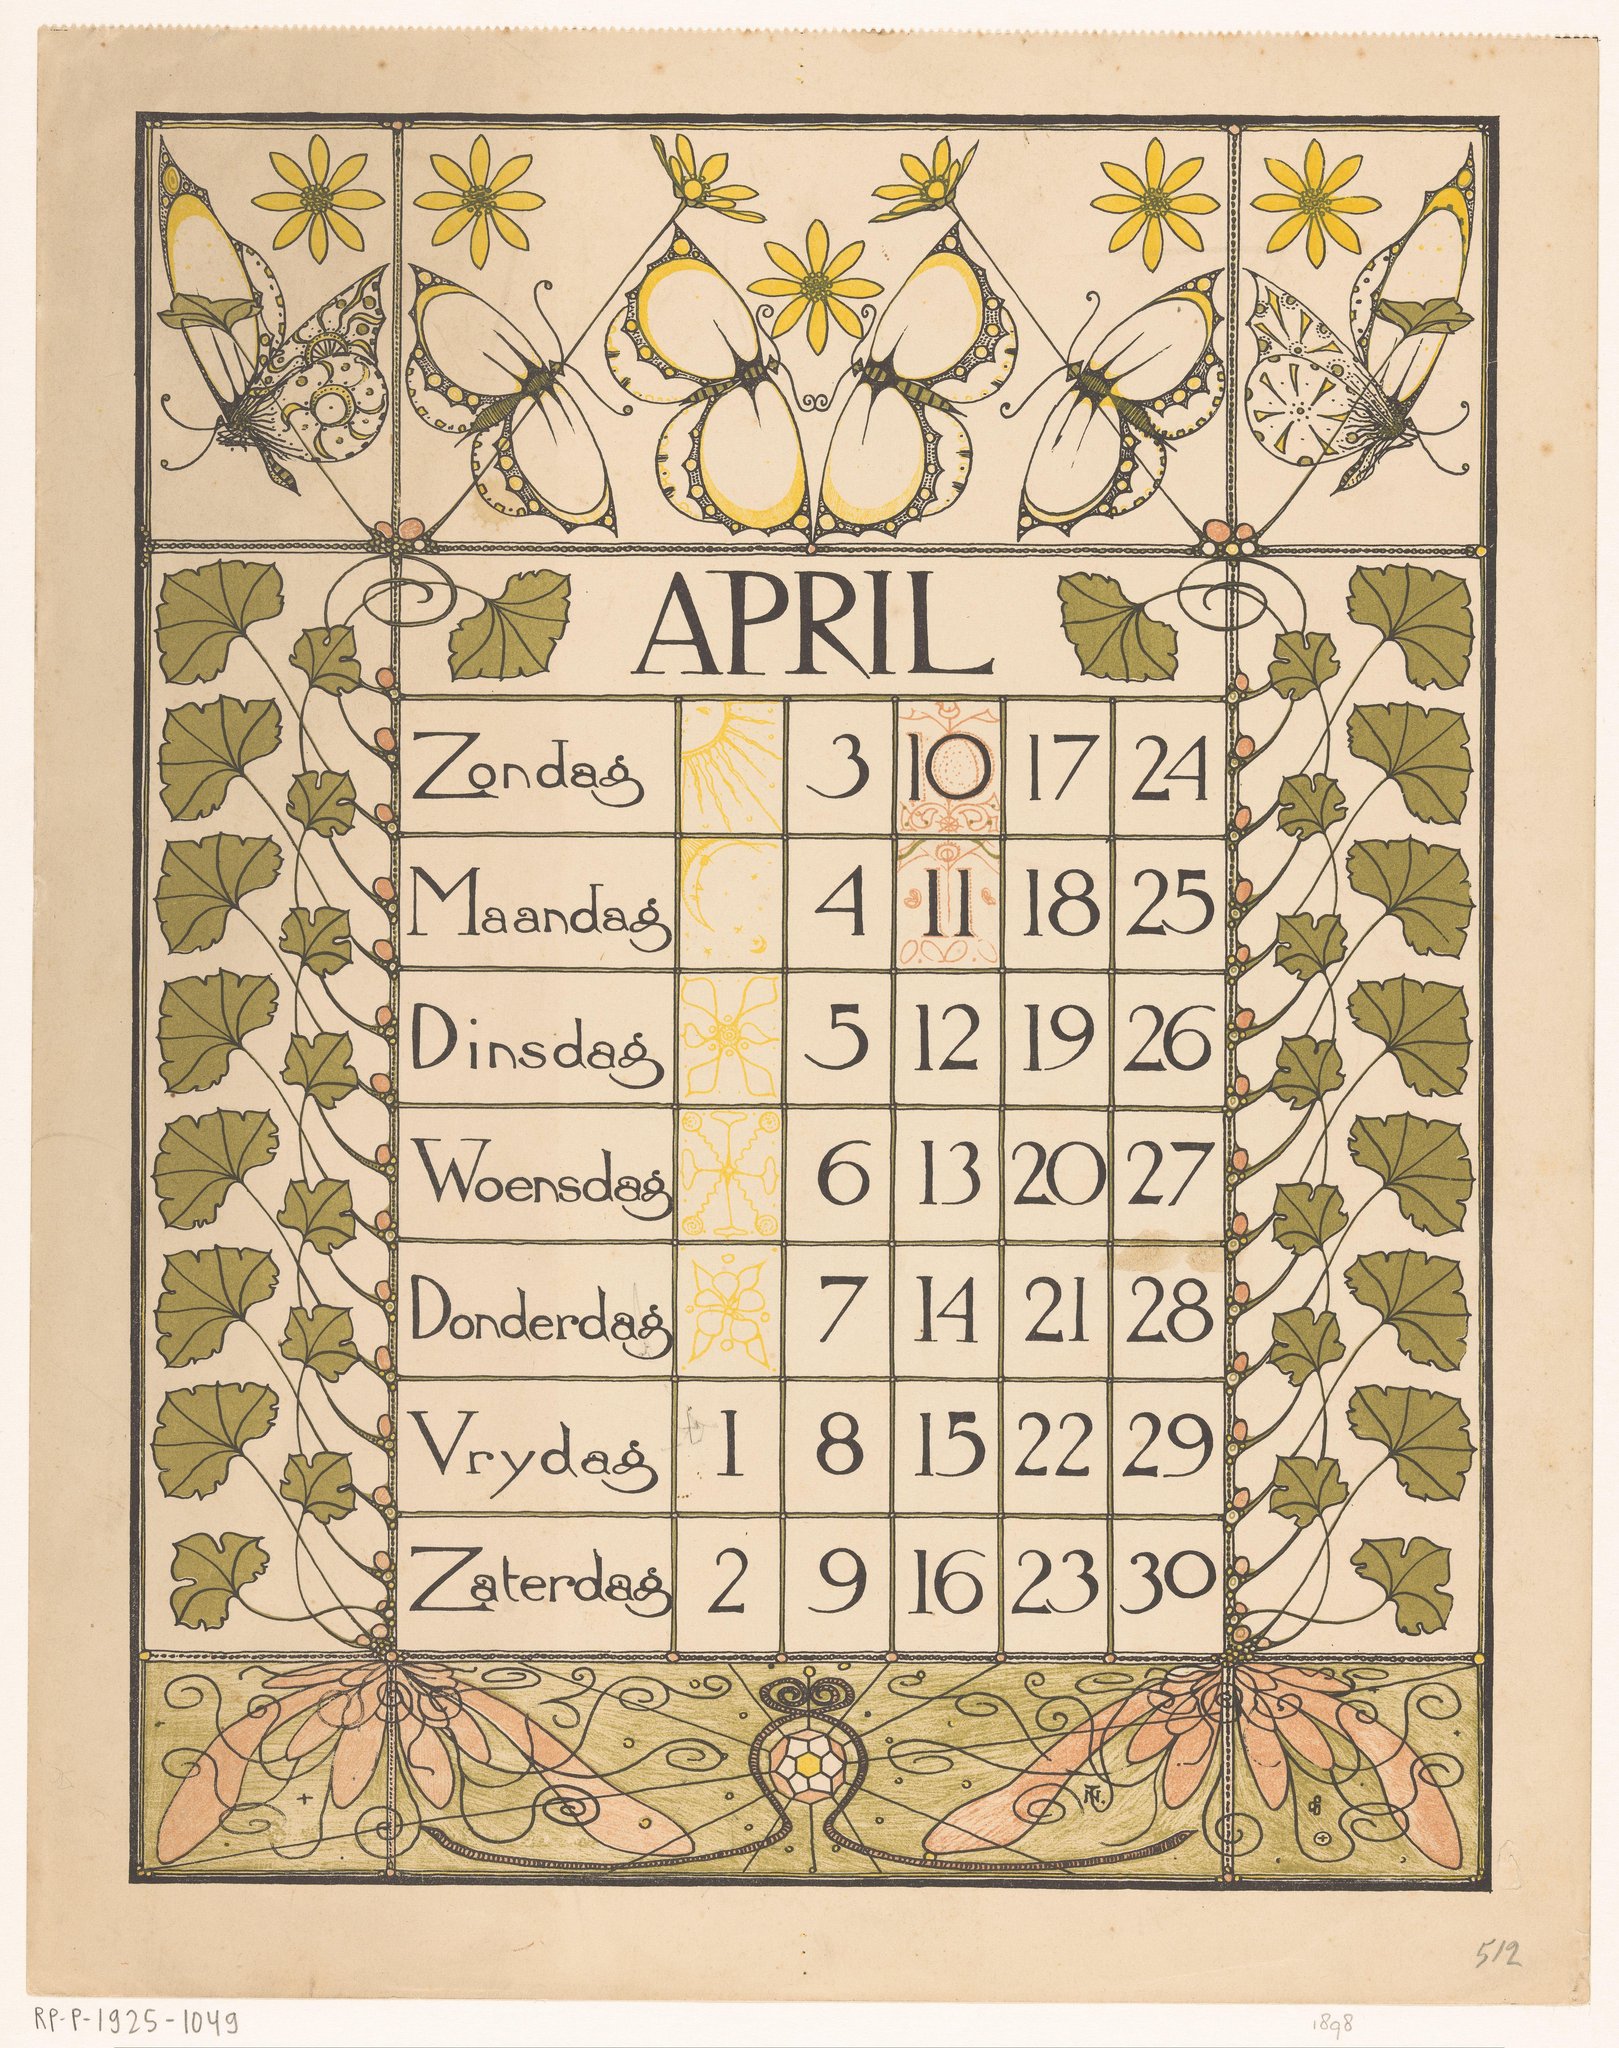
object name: print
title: Kalenderblad voor april 1898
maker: theo nieuwenhuis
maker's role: designer, draughtsman, print maker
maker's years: 1866-1951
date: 1897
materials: paper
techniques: lithograph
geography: amsterdam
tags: insects: butterfly, ornament derived from plant forms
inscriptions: collector's mark: Lugt 2228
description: Een rechthoekig kader met de dagen van de maand april en daaromheen speenkruid en vlinders.